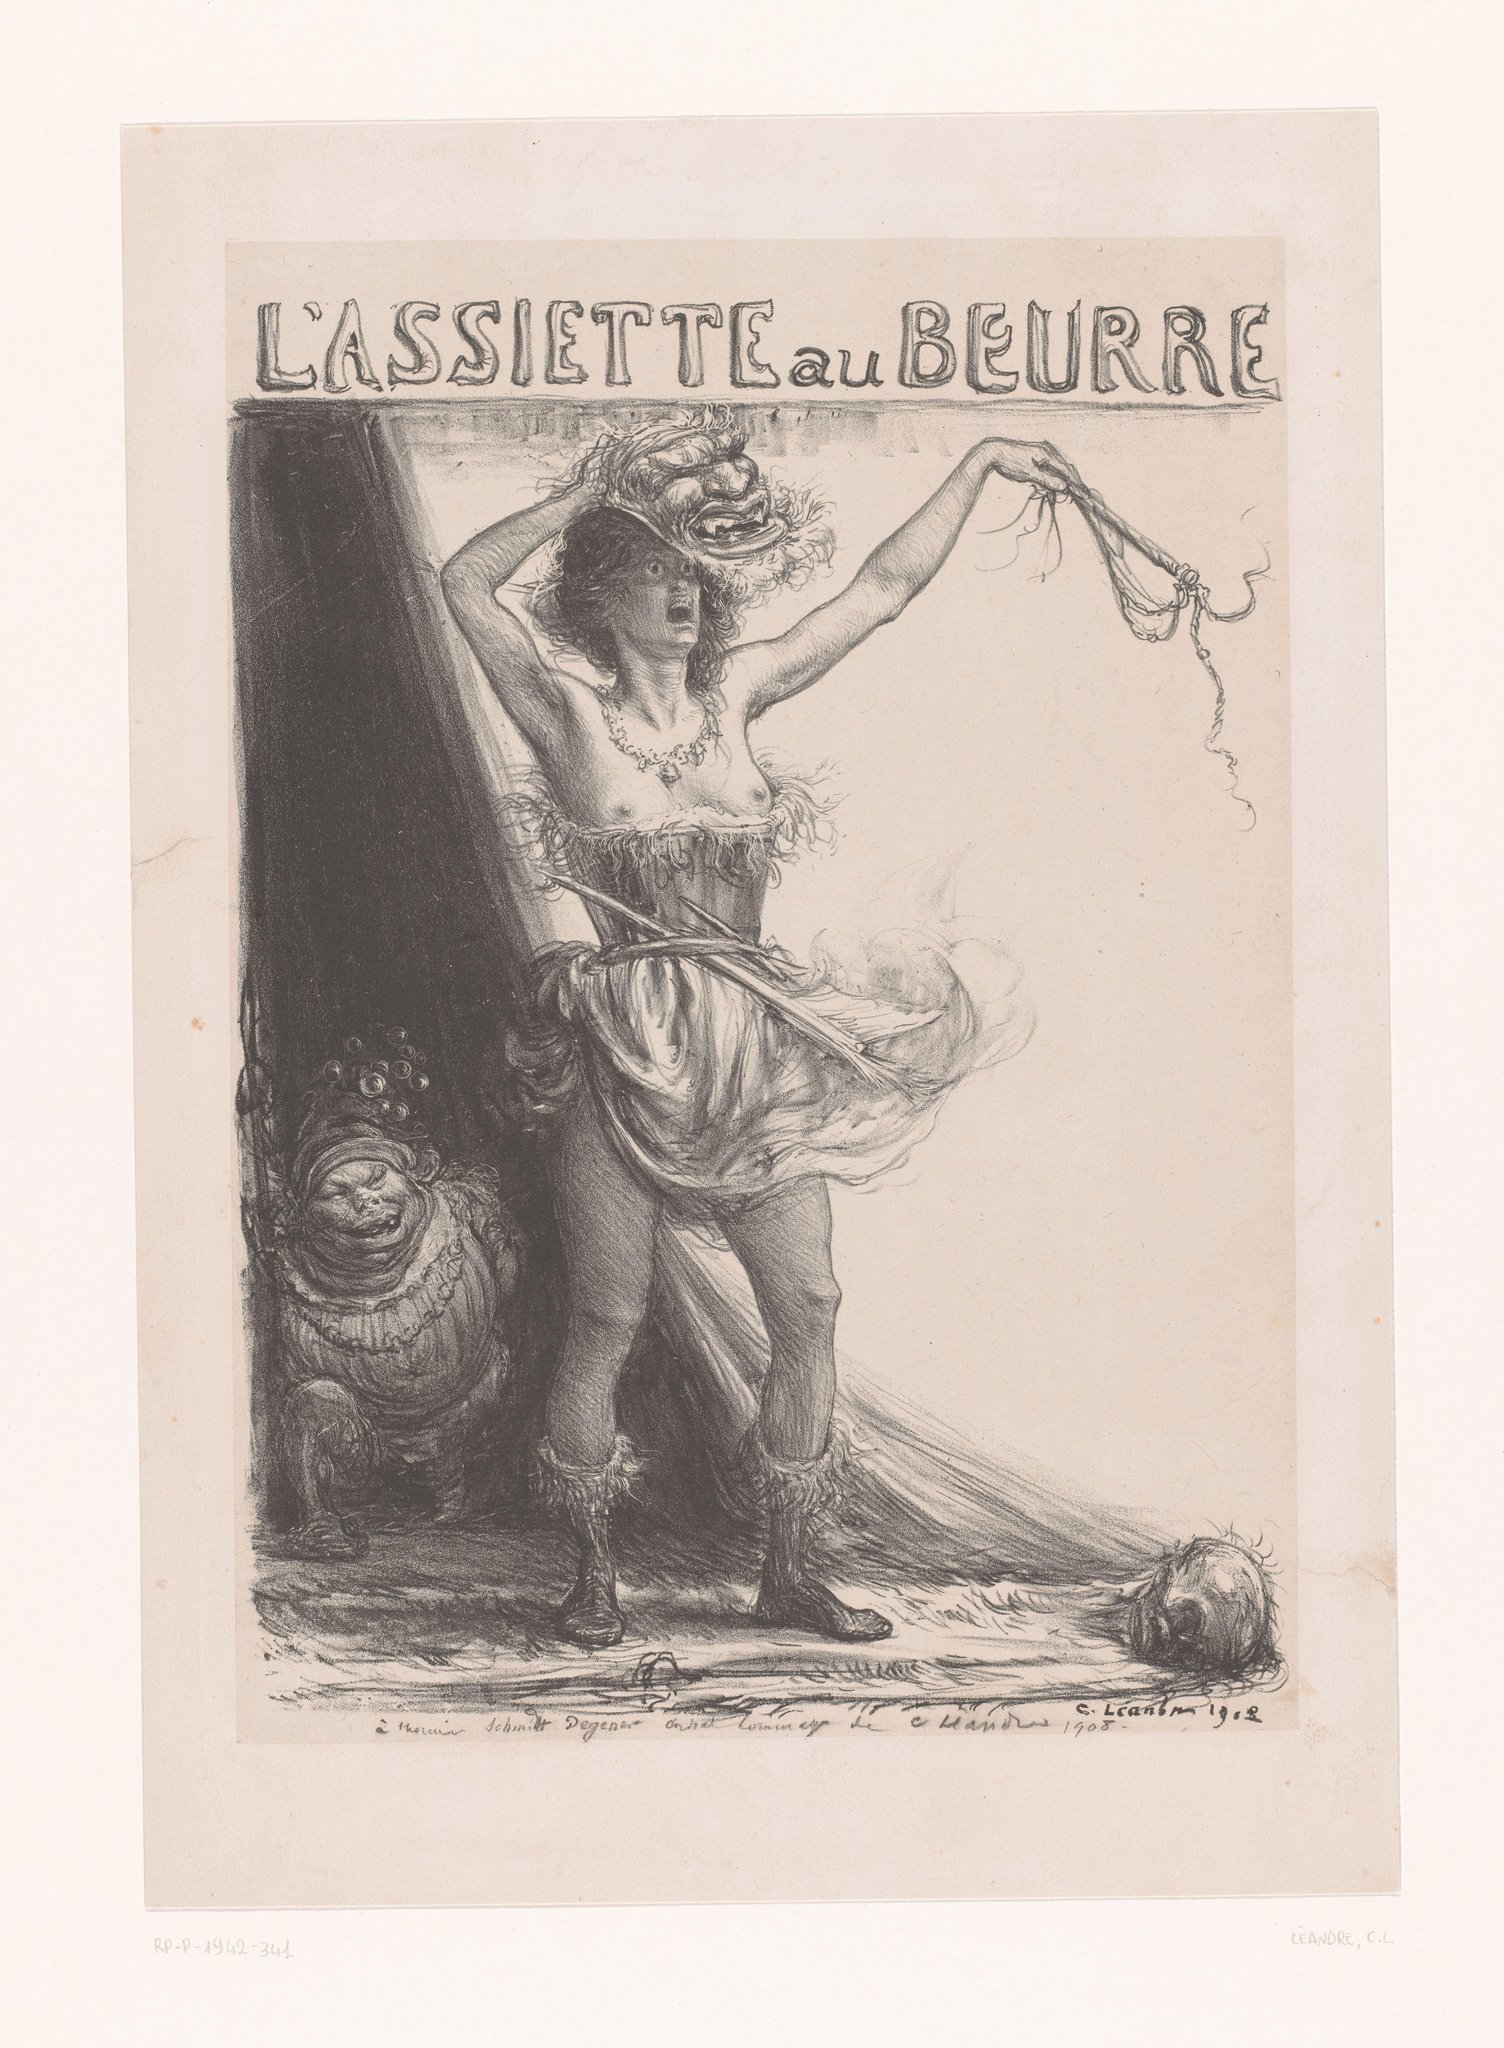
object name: cartoon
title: Le Journaliste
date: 1902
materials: paper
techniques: lithography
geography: paris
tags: mask, theatre, theatrical performance, wild man, wodewose, woodehouse - aa - female, goblins, hobgoblins, whip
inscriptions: collector's mark: Lugt 2228a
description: Prent gebruikt voor: L'Assiette au beurre, nr. 79, 1902.